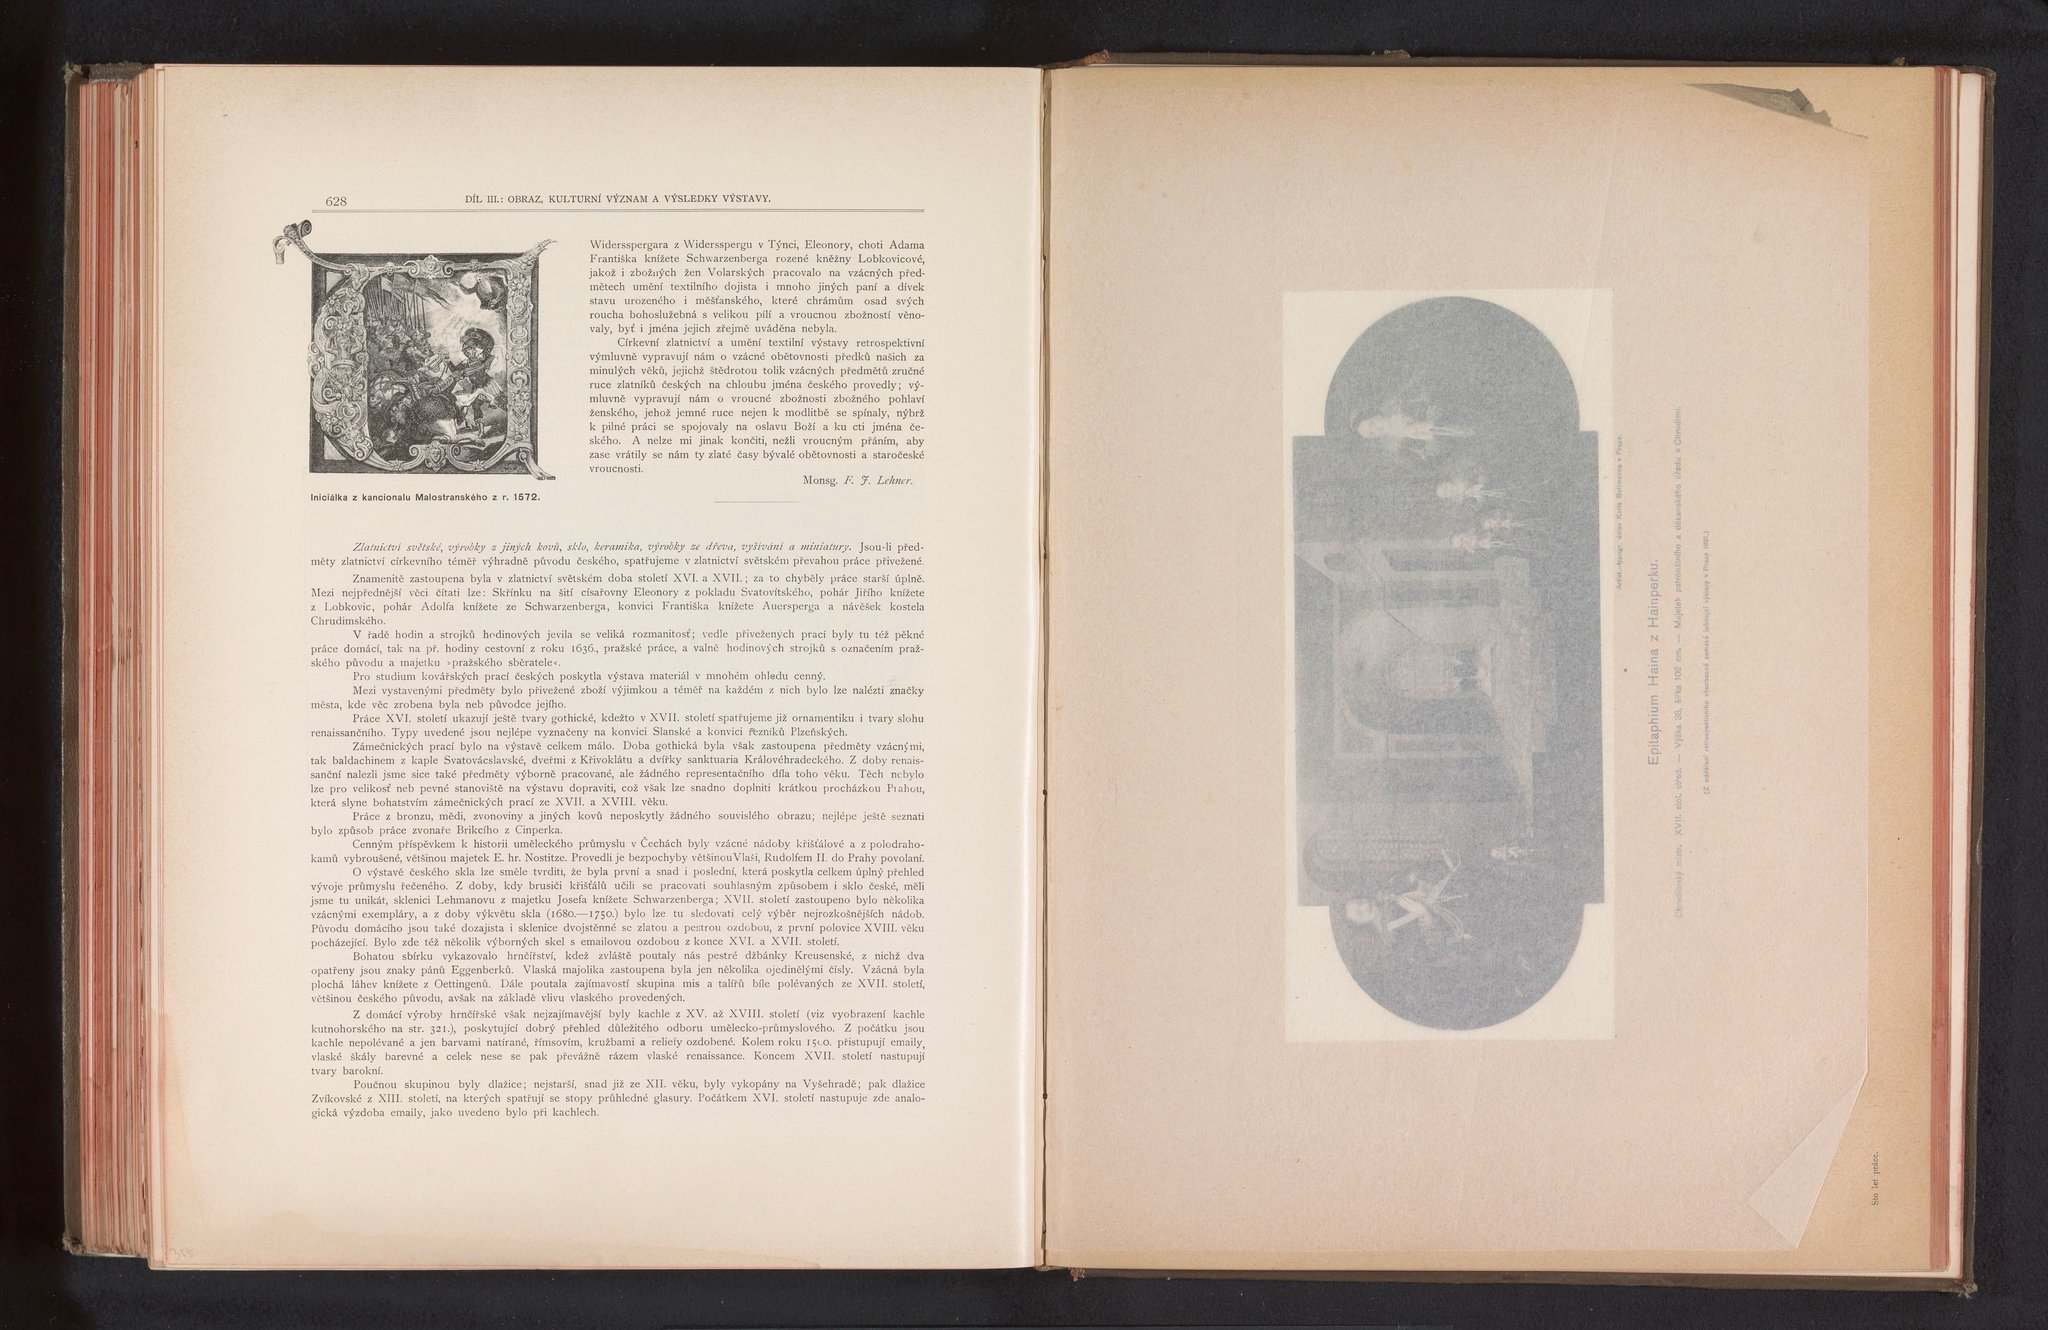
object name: photomechanical print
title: Fotoreproductie van een initiaal uit een gebedenboek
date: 1891-1895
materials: paper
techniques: autotype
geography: prague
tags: initial